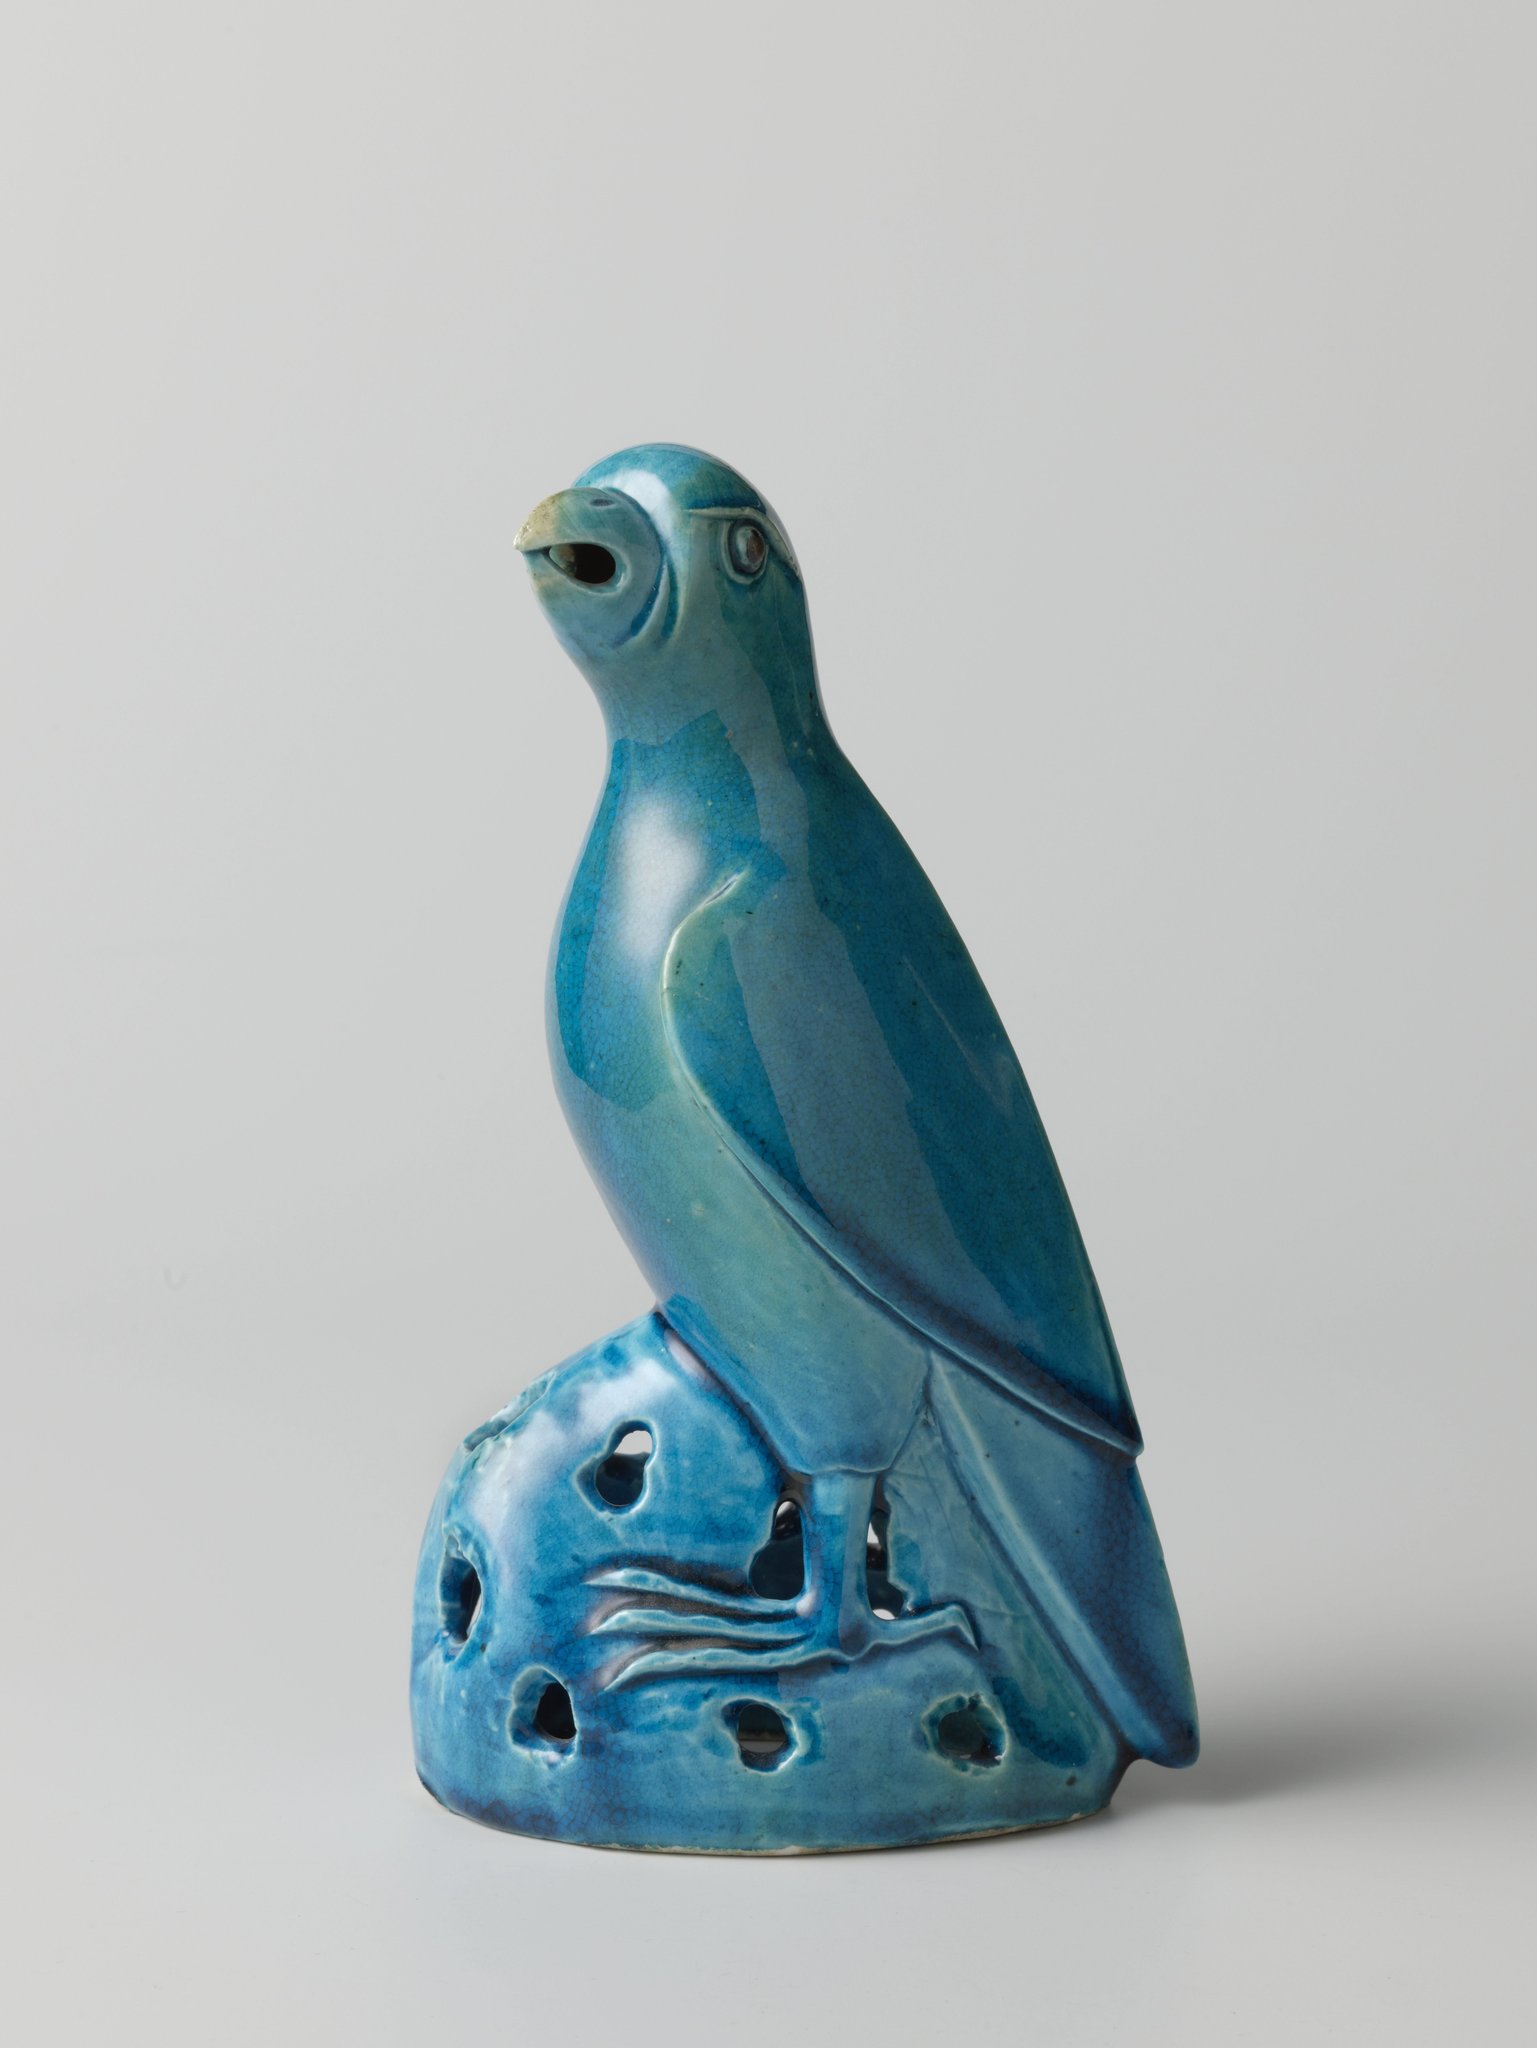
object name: figure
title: Figure of a parrot on a rock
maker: Anonymous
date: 1700-1799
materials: glaze, porcelain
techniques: embroidery, firing, forming, vitrification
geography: china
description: Two Figurines of a Parrot on a Rock. Derived from copper and potash (potassium carbonate), turquoise was first used as a glaze colour in the 15th century. After the porcelain body had been fired at a high temperature, the turquoise was applied and the piece fired again at a lower temperature. The glaze has a glassy appearance and at times displays some crackle on the surface.